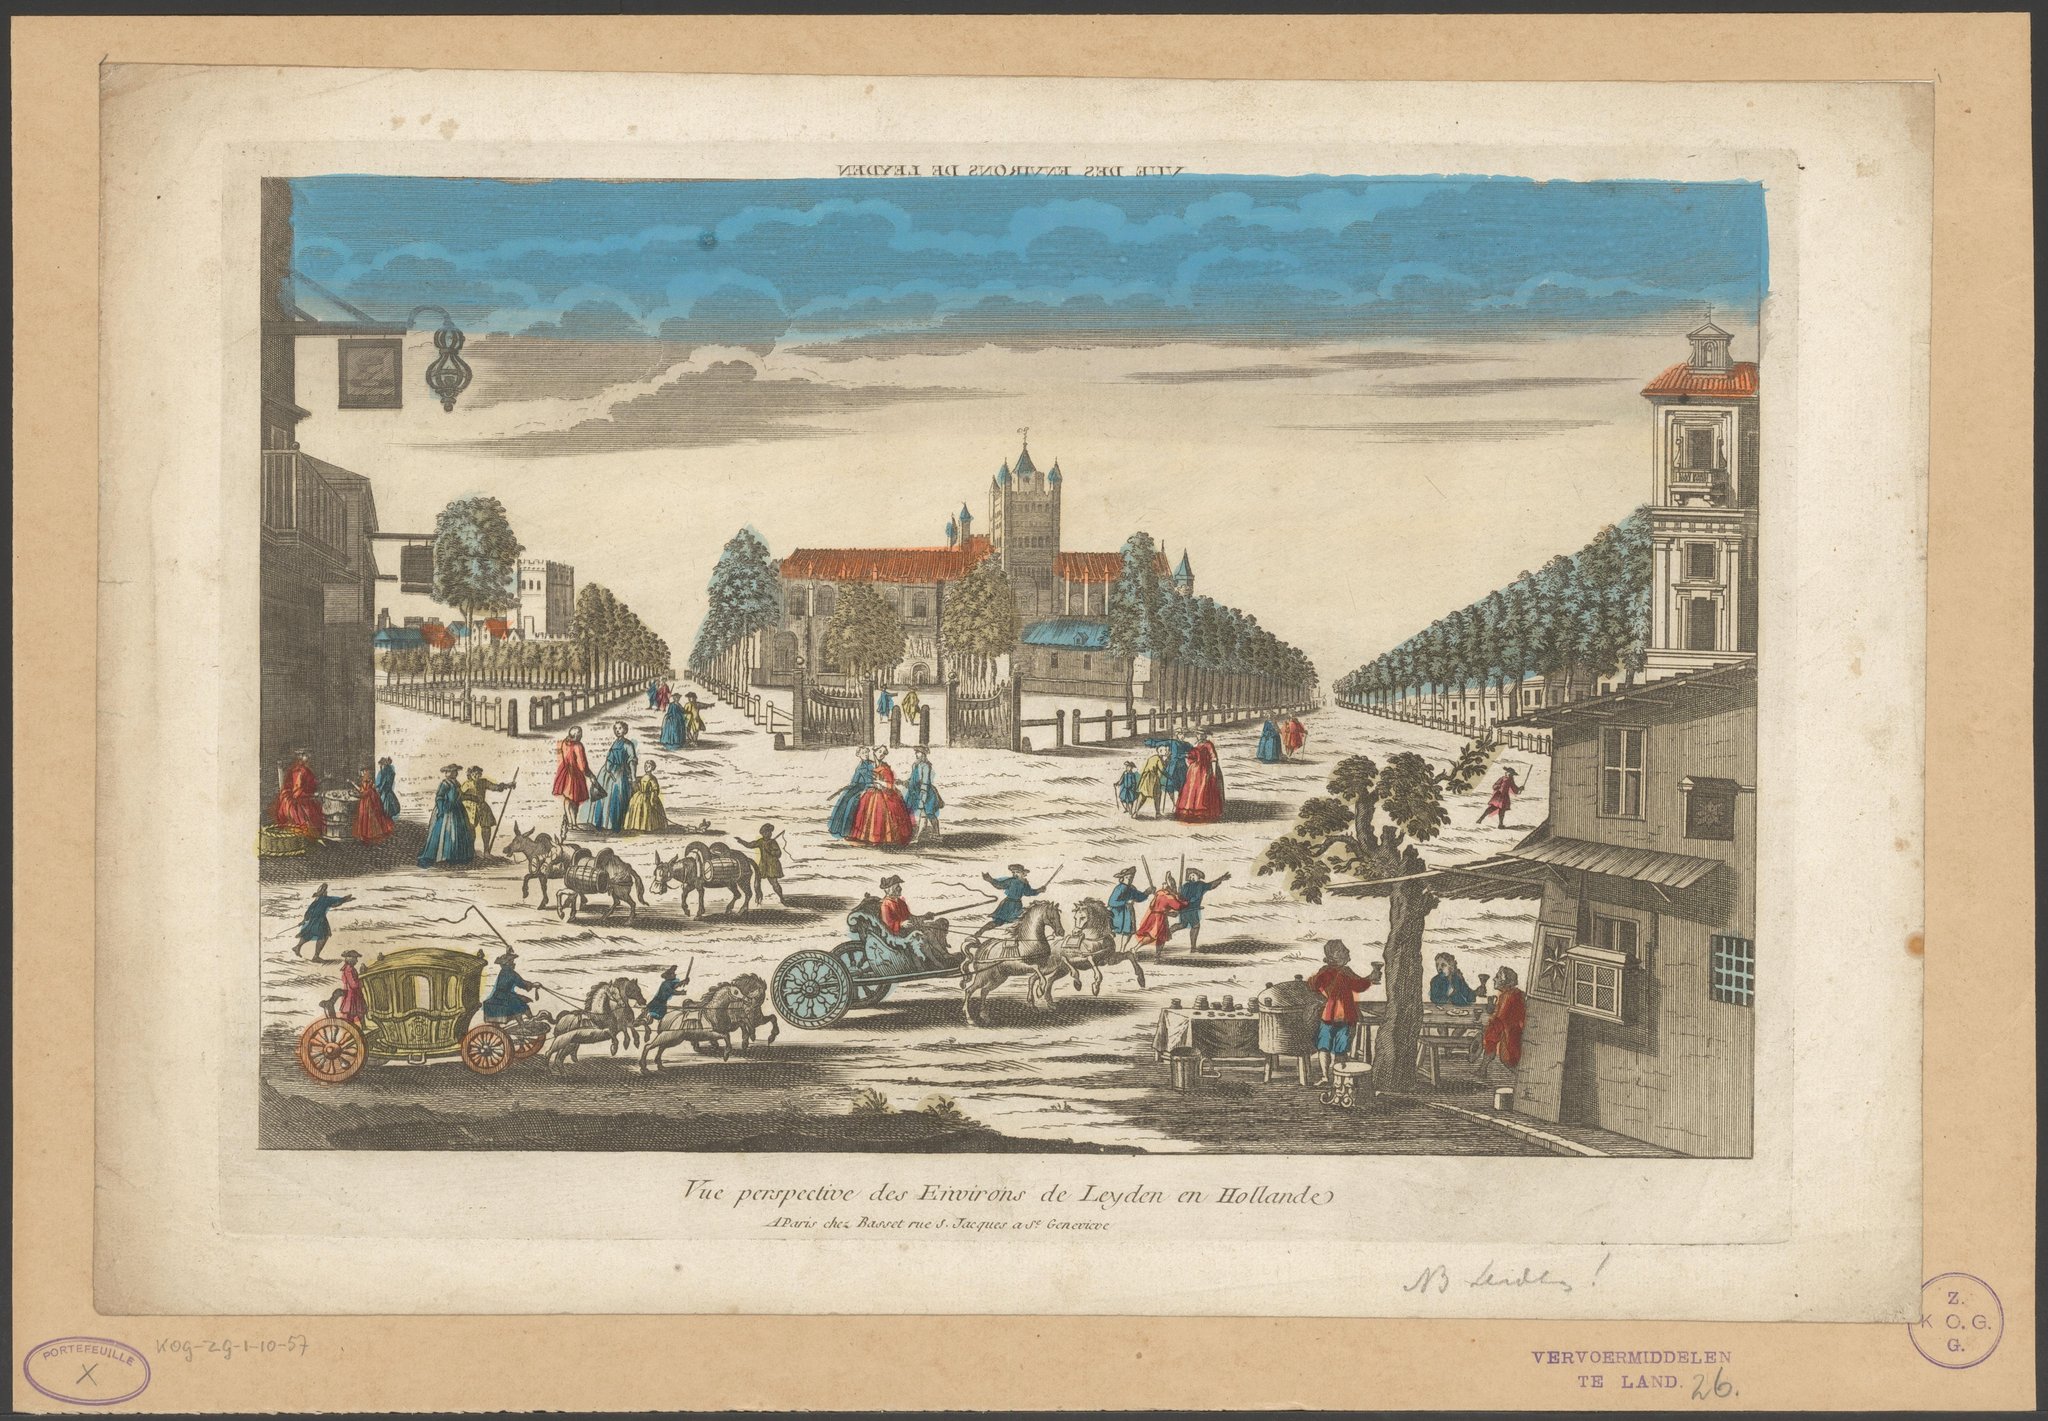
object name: print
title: Vue perspective des Environs de Leyden en Hollande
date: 1700-1799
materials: paper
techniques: engraving, etching, hand coloring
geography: paris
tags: ass, donkey, castle, horse, postman, lane, alley, leiden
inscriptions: stamp, stamp, collector's mark: Lugt 1641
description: Perspectiefprent met twee lanen langs een kasteel in de buurt van Leiden. Onderwerpsrubrieken binnen de Atlas Zeden en Gewoonten: Vervoermiddelen te land en te water, Vervoermiddelen te land, Rijtuigen en Statiekarossen.